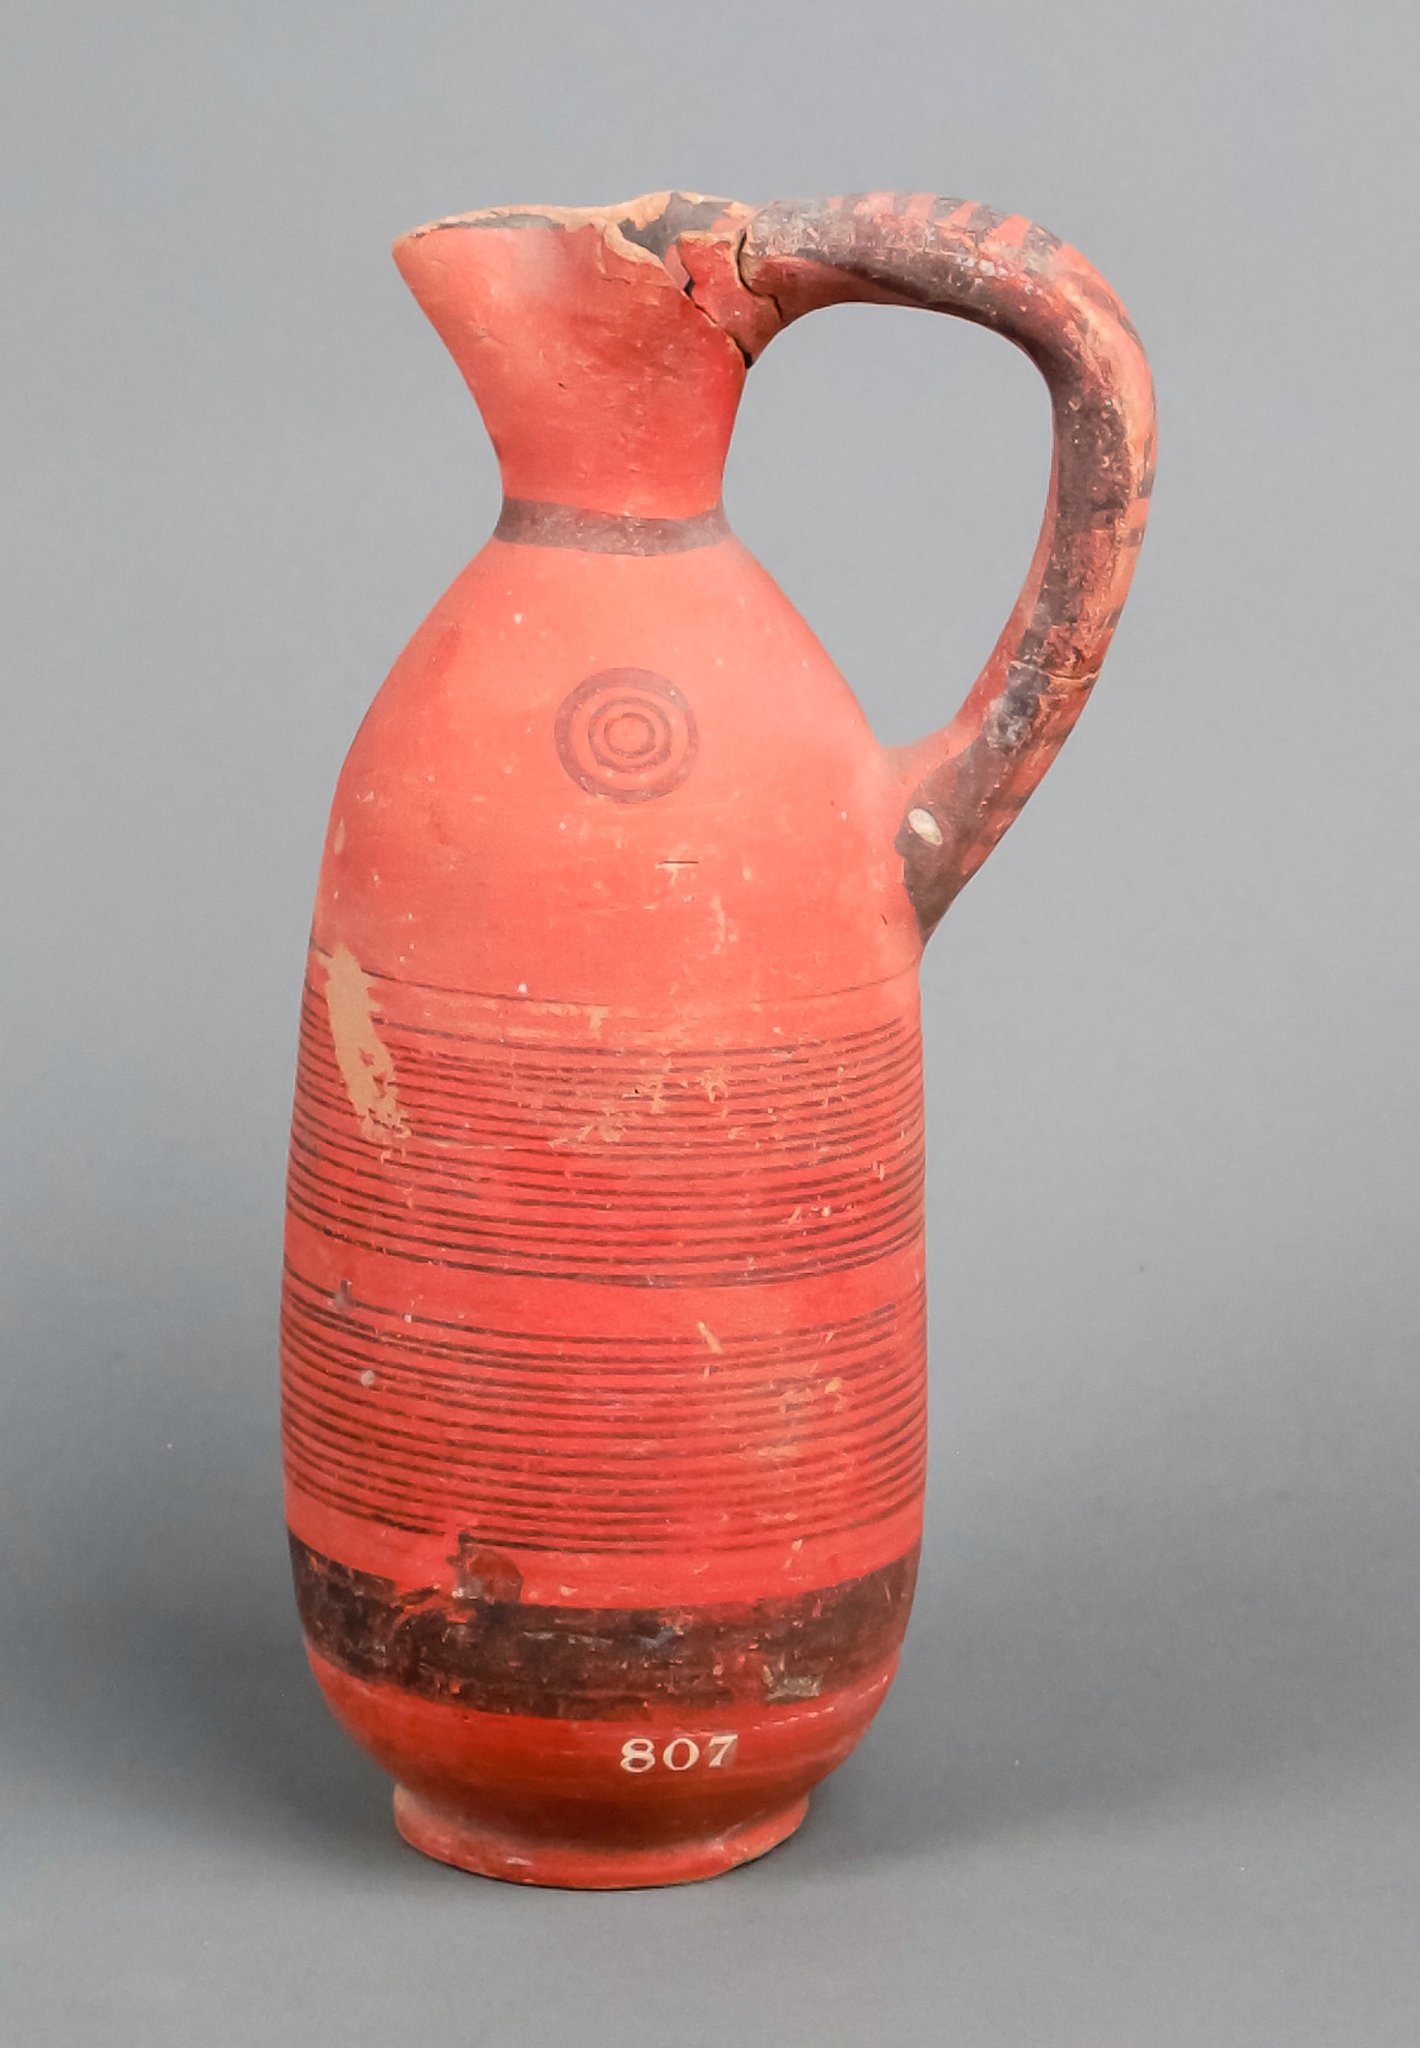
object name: jug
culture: cypriot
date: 750-600 BCE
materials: terracotta